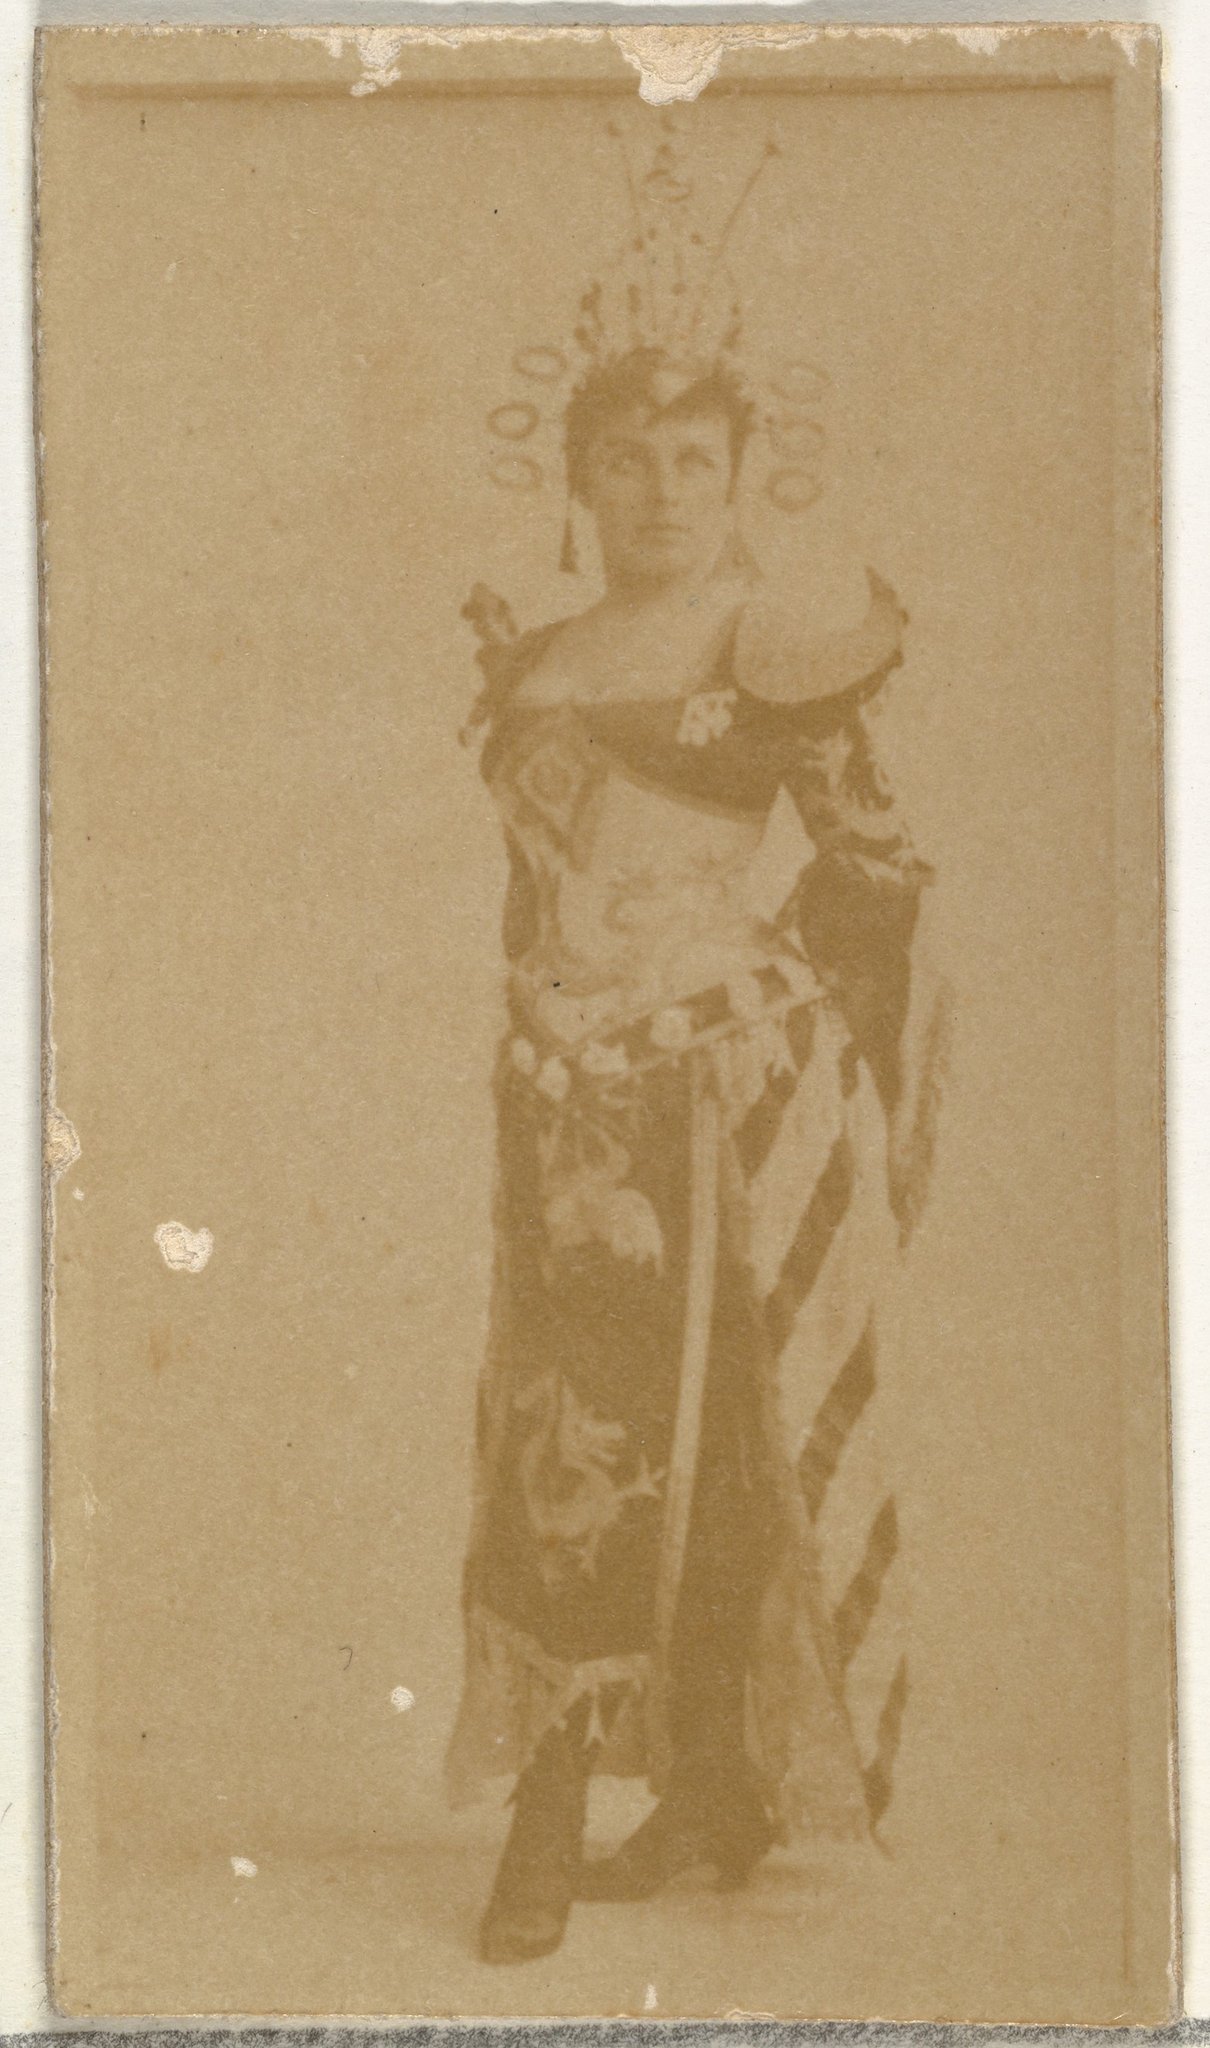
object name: photograph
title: [Actress wearing tall headpiece], from the Actors and Actresses series (N145-8) issued by Duke Sons & Co. to promote Duke Cigarettes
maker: w. duke, sons & co.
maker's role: publisher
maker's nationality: american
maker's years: 1870-1920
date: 1891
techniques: albumen silver print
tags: portraits,women,actresses